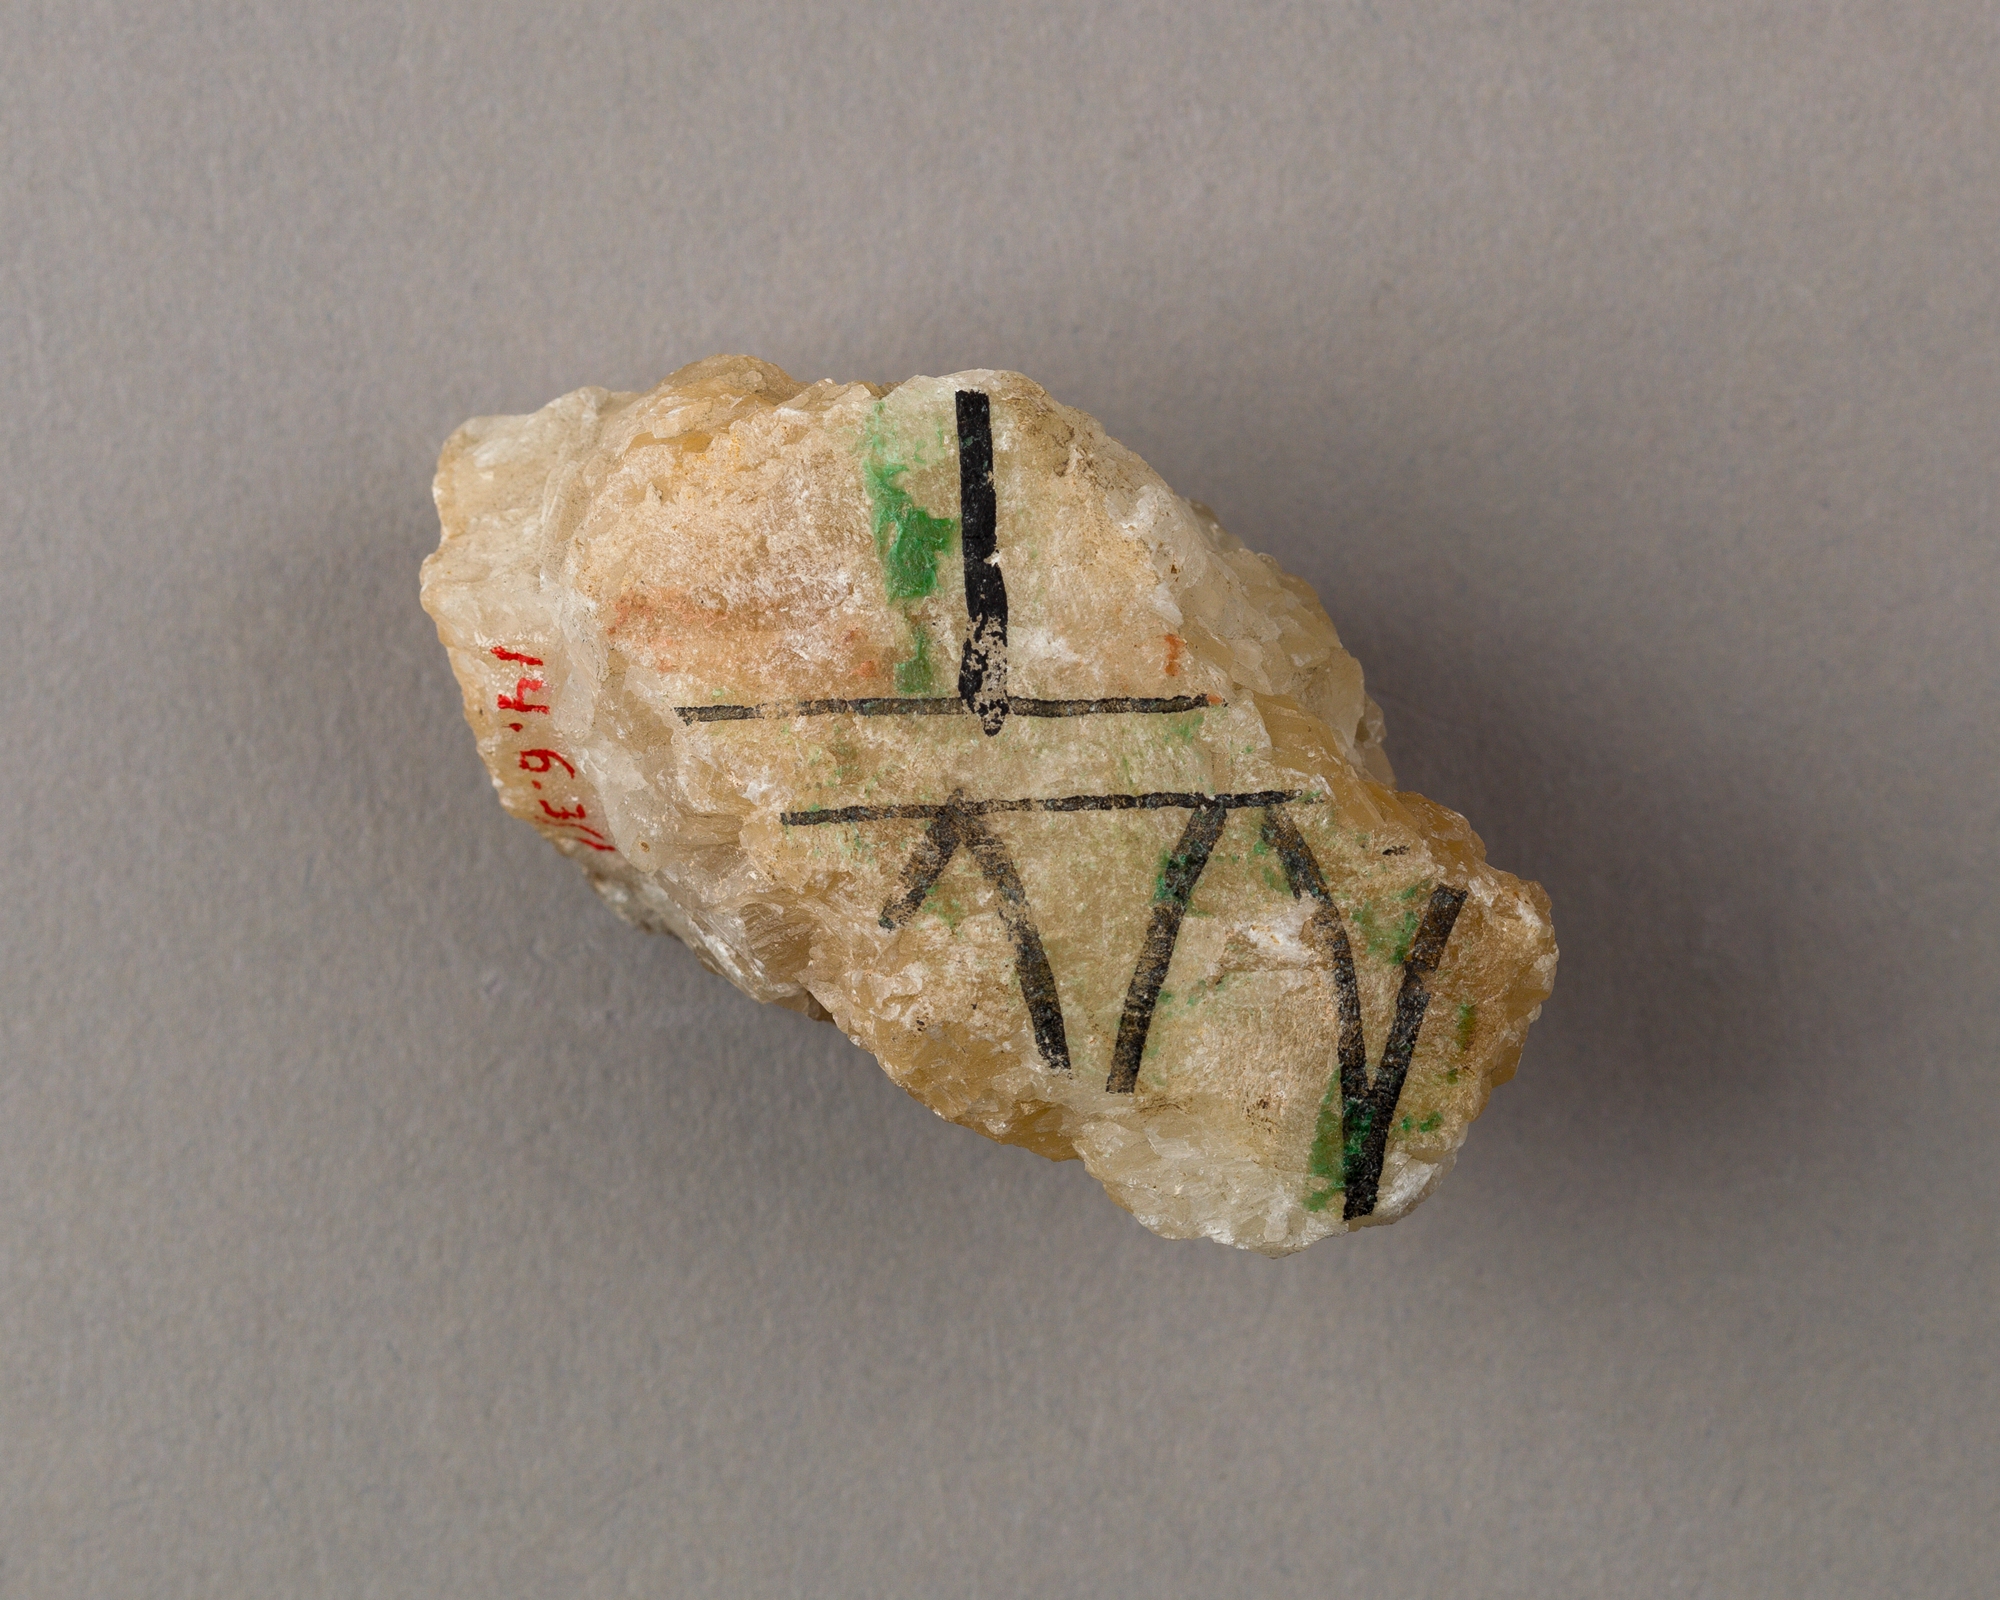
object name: jar fragment, siptah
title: Jar Fragment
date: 1194-1188 BCE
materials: stone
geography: egypt